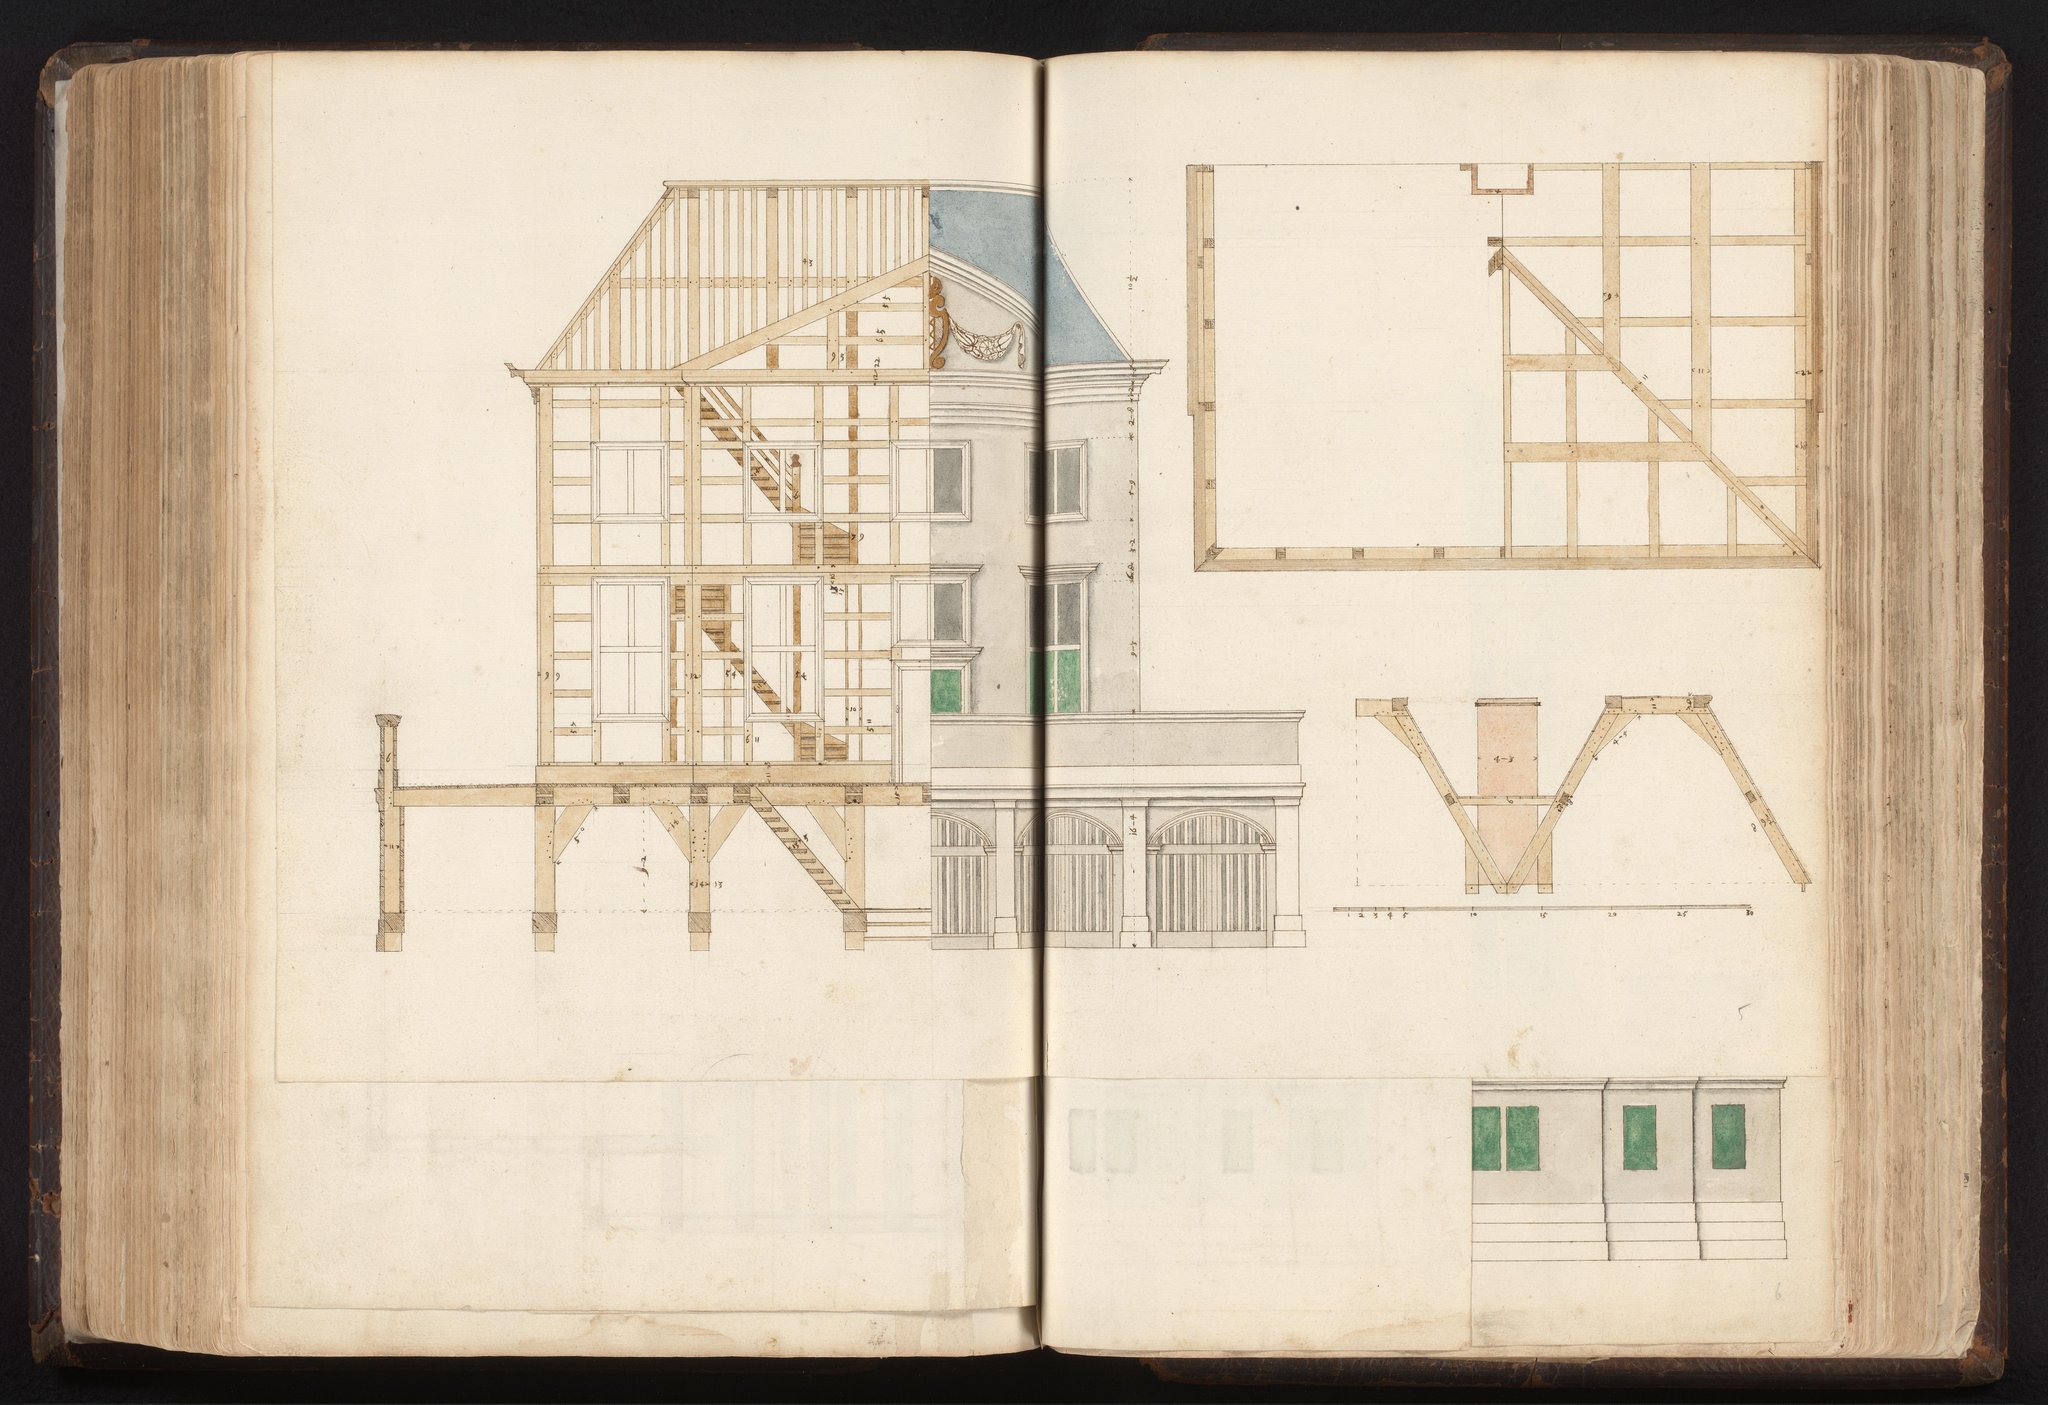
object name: album leaf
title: Gevel, skelet en doorsnede van een Blokhuis in de Amstel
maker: Anonymous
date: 1650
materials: paint, ink, paper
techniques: brush, pen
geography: amsterdam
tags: building activities, fortified city, section ~ architectural design or model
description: Met afmetingen en een schaalaanduiding. Tekening maakt deel uit van een album.